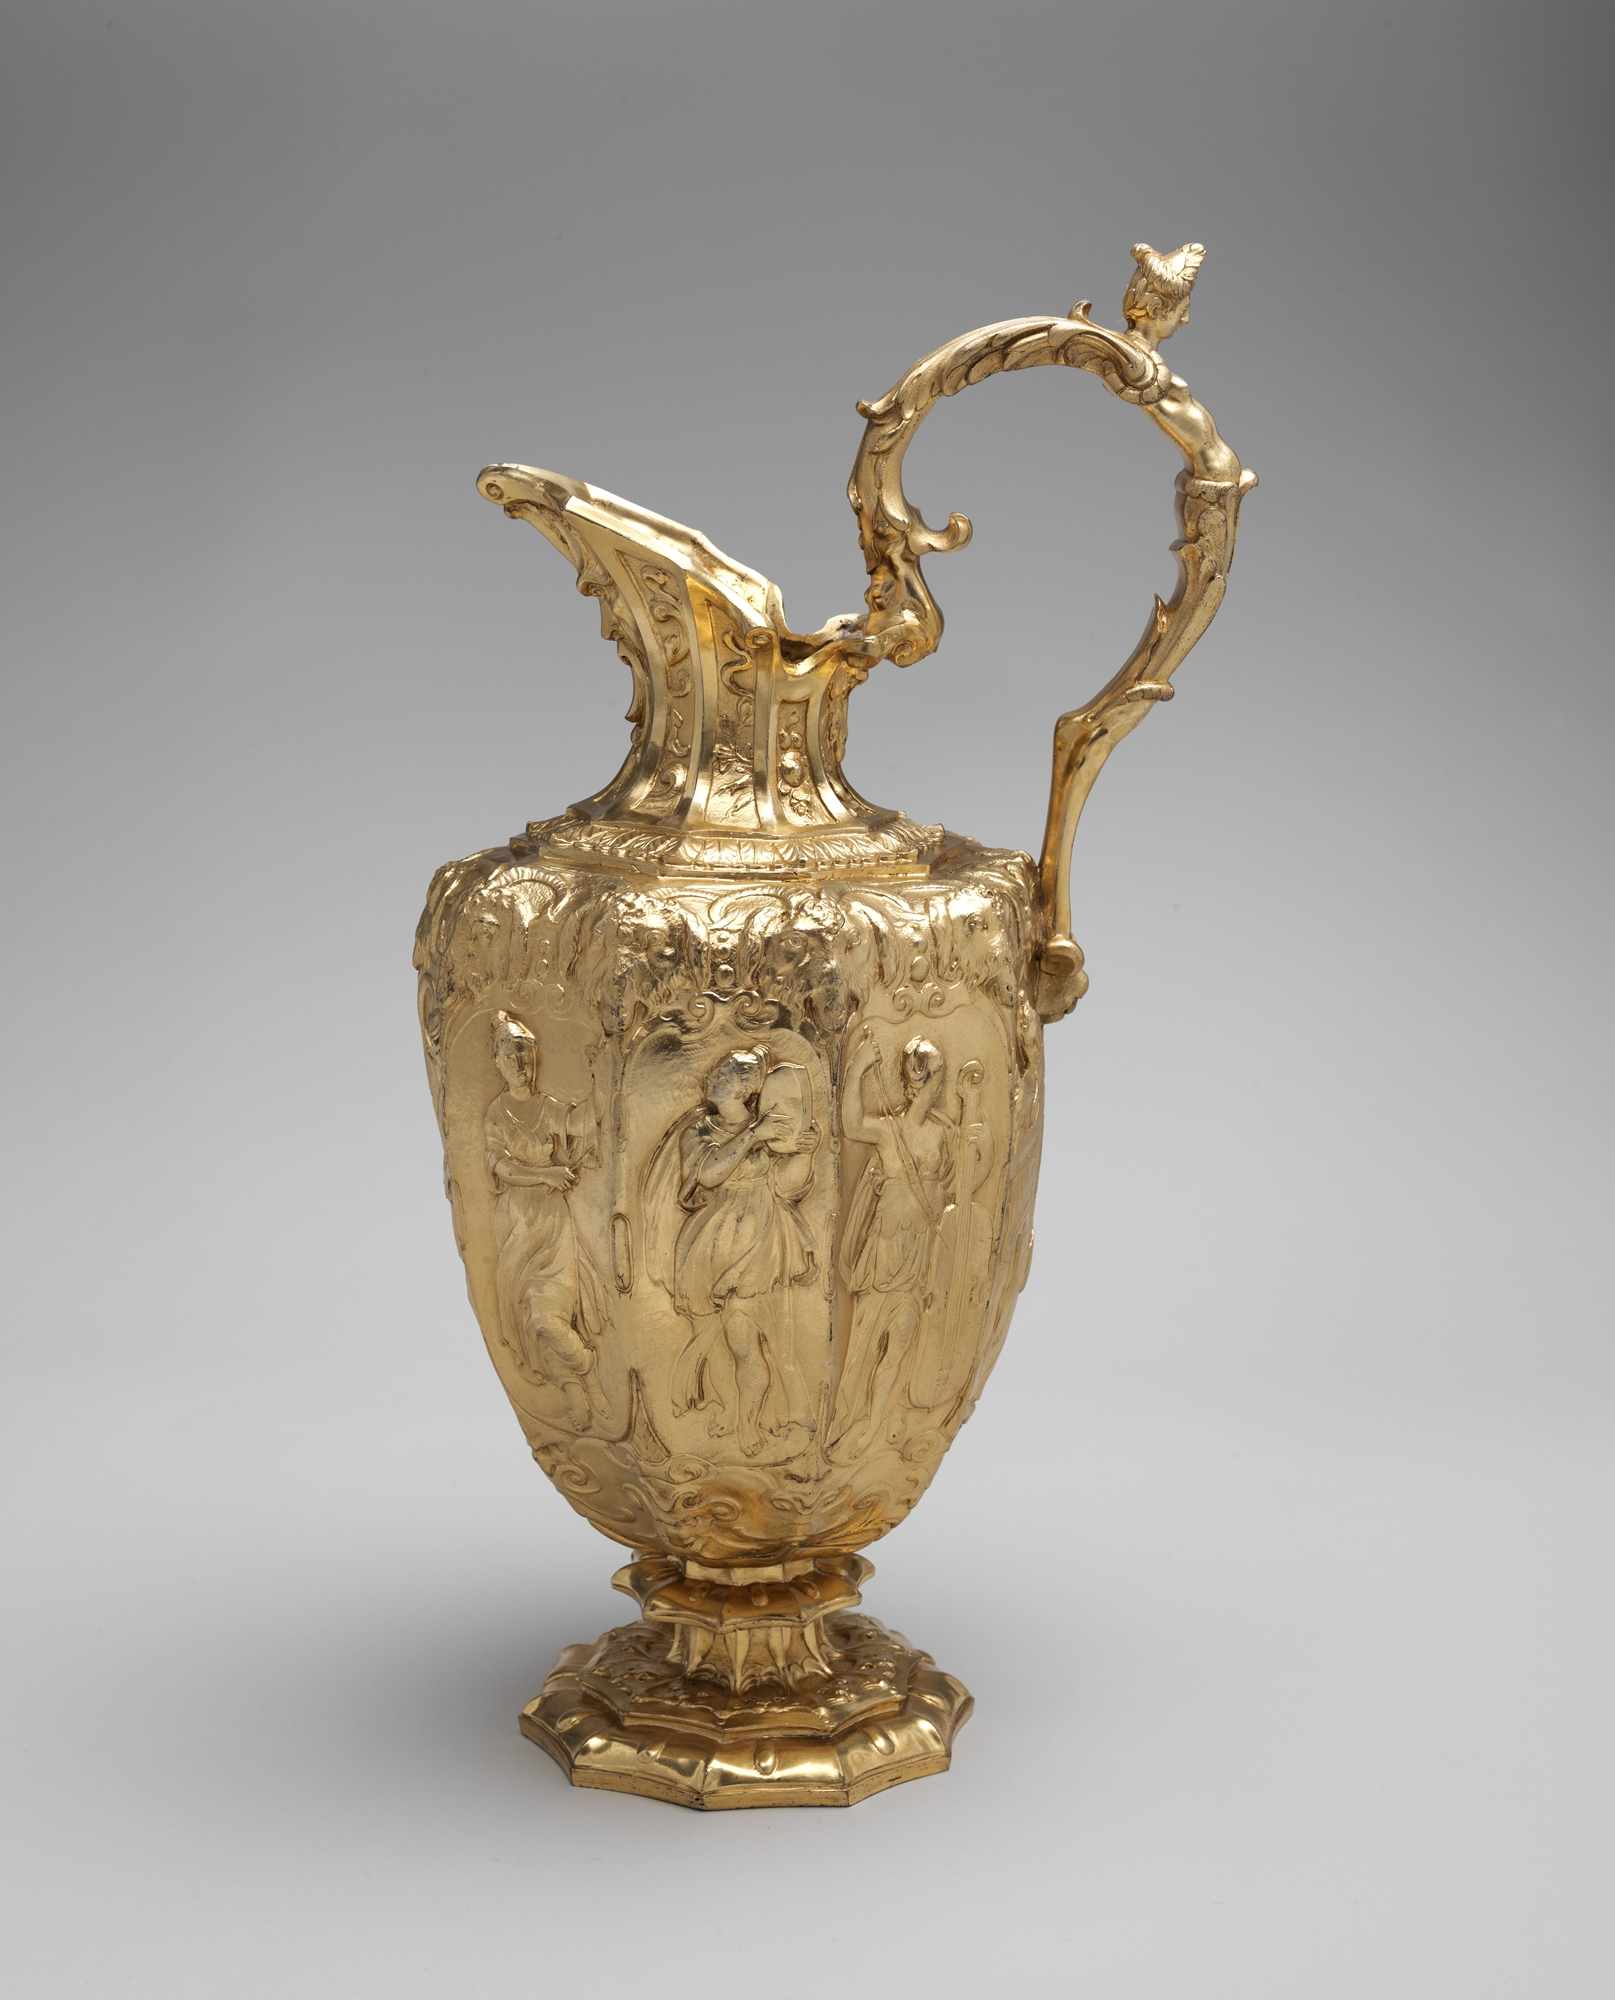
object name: ewer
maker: elkington & co.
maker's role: manufacturer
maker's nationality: british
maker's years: 1829-1963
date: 1801-1900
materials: metal, silver gilt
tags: musical instruments,heads,men,women